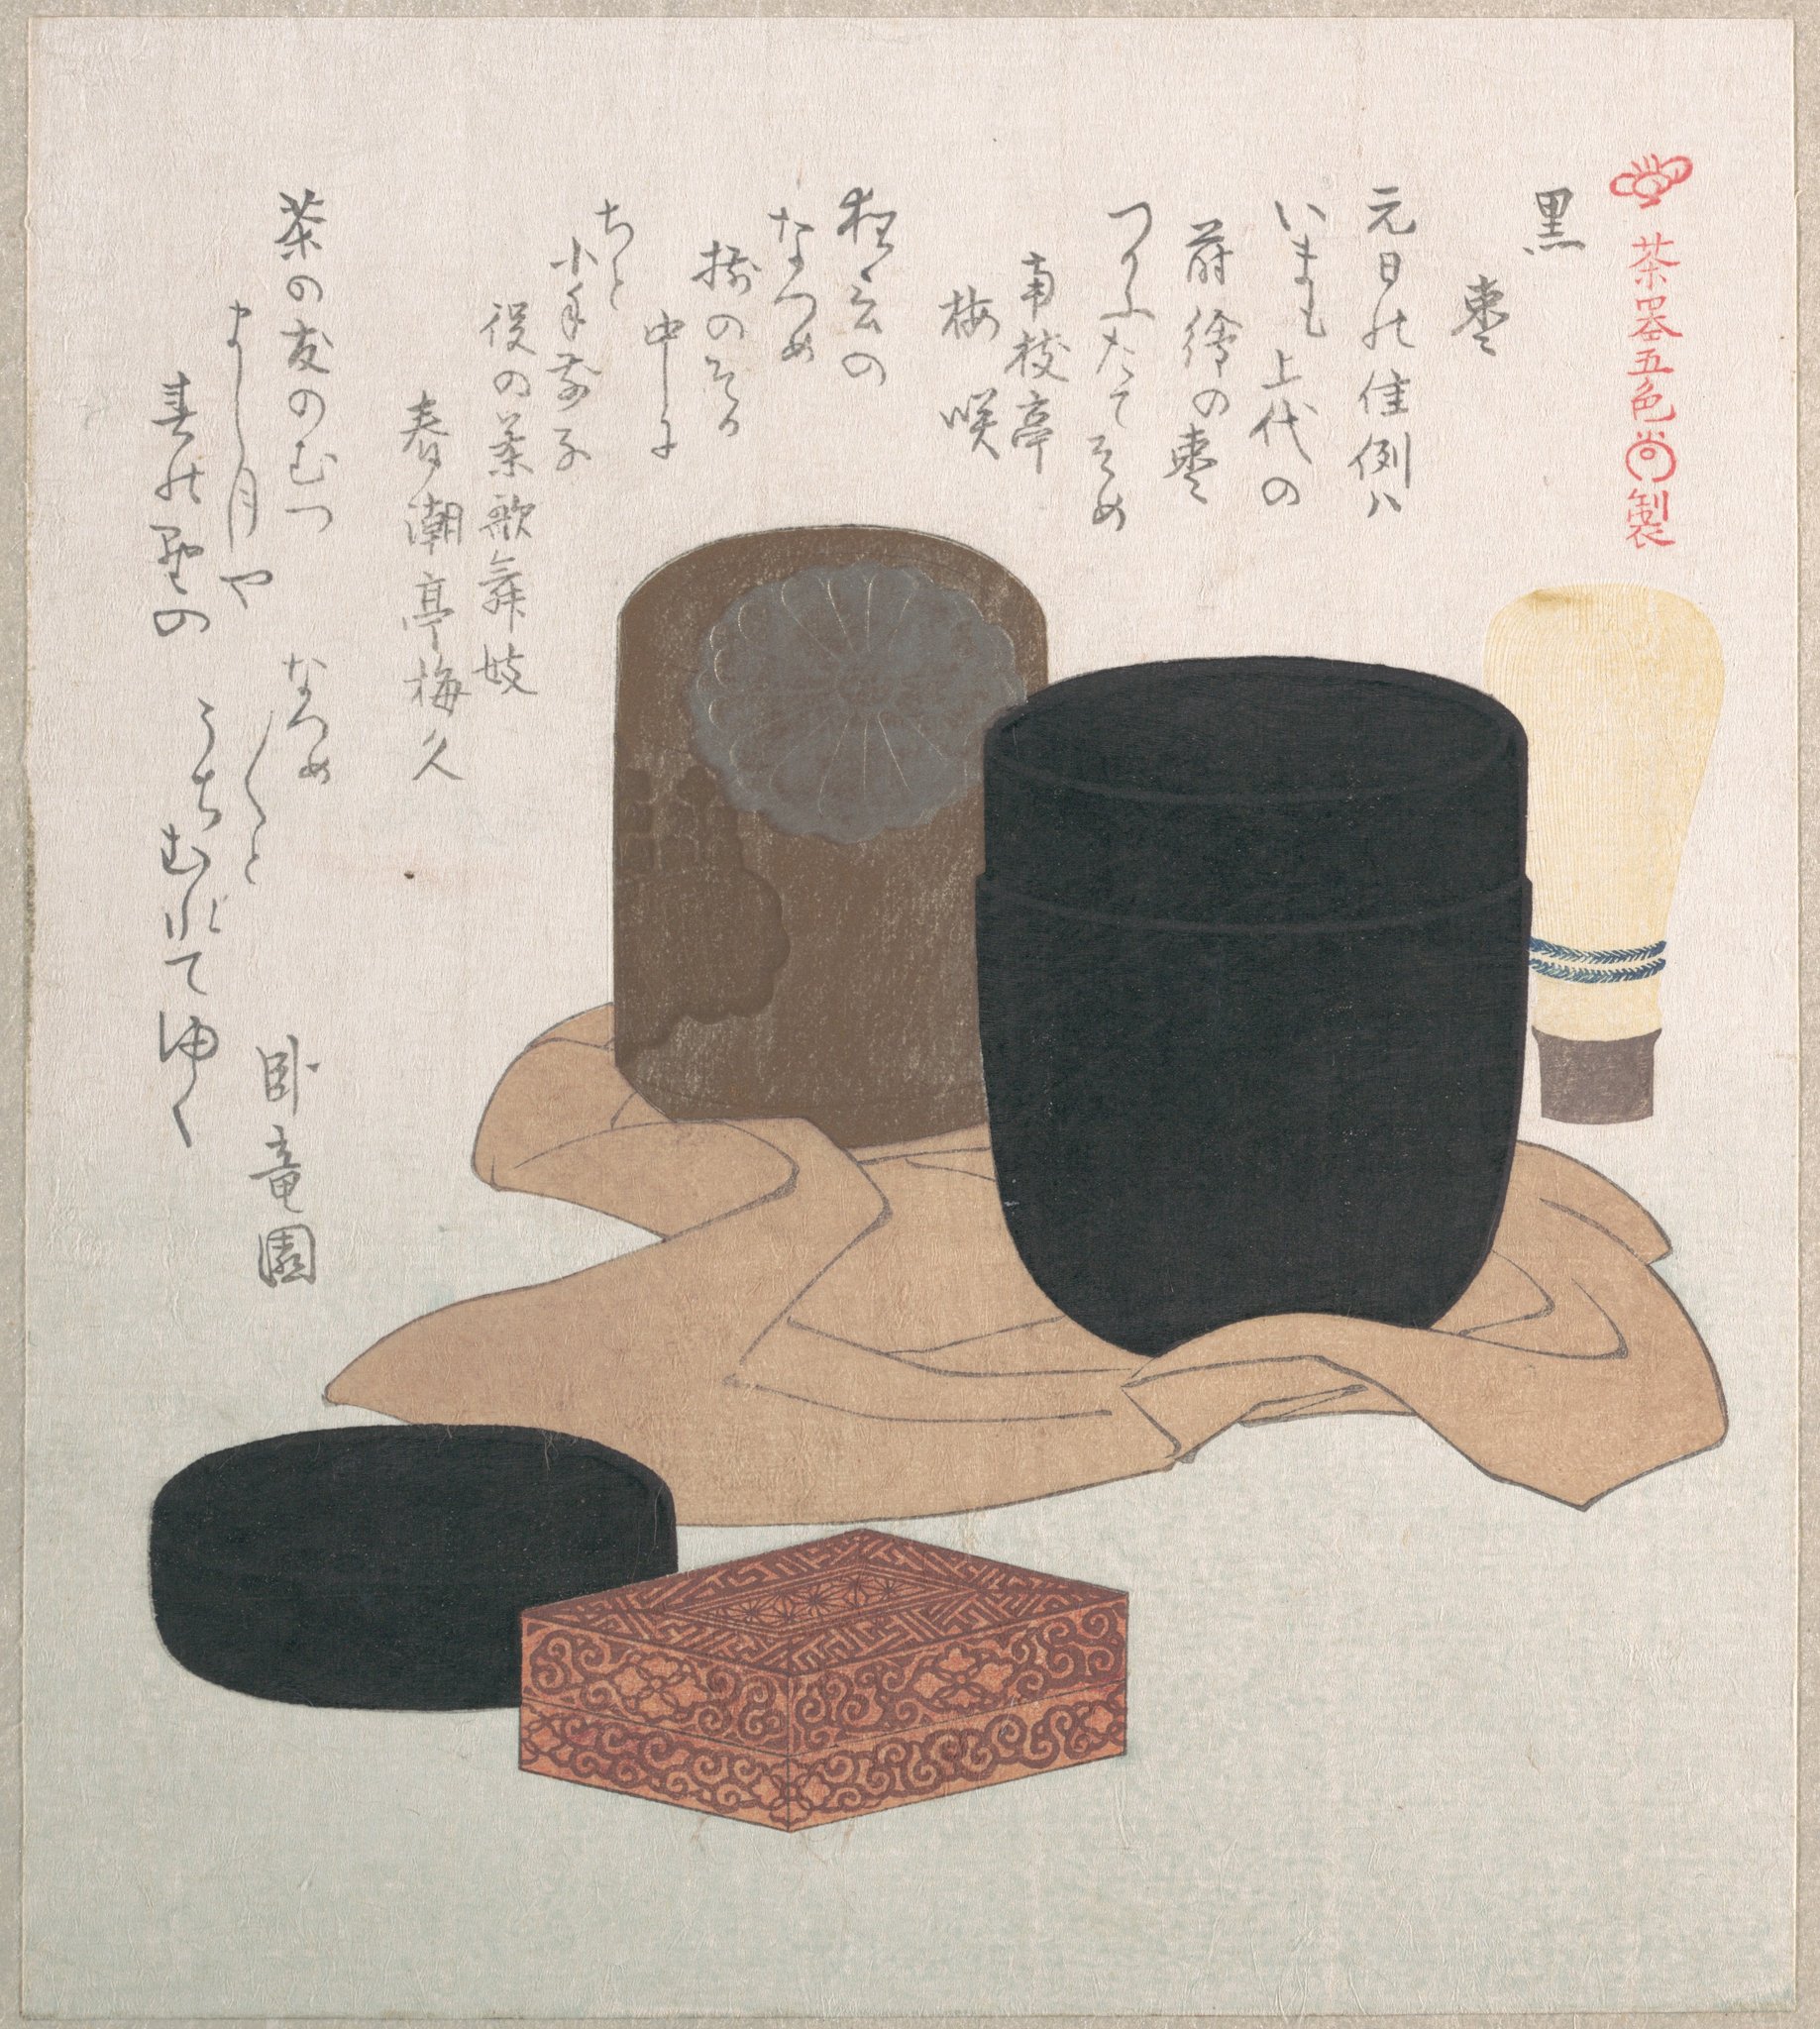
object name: print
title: Black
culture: japanese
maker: kubo shunman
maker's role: artist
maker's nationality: japanese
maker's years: 1757-1820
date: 1801-1900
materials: ink, paper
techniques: surimono, woodblock print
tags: tea caddy,tea ceremony